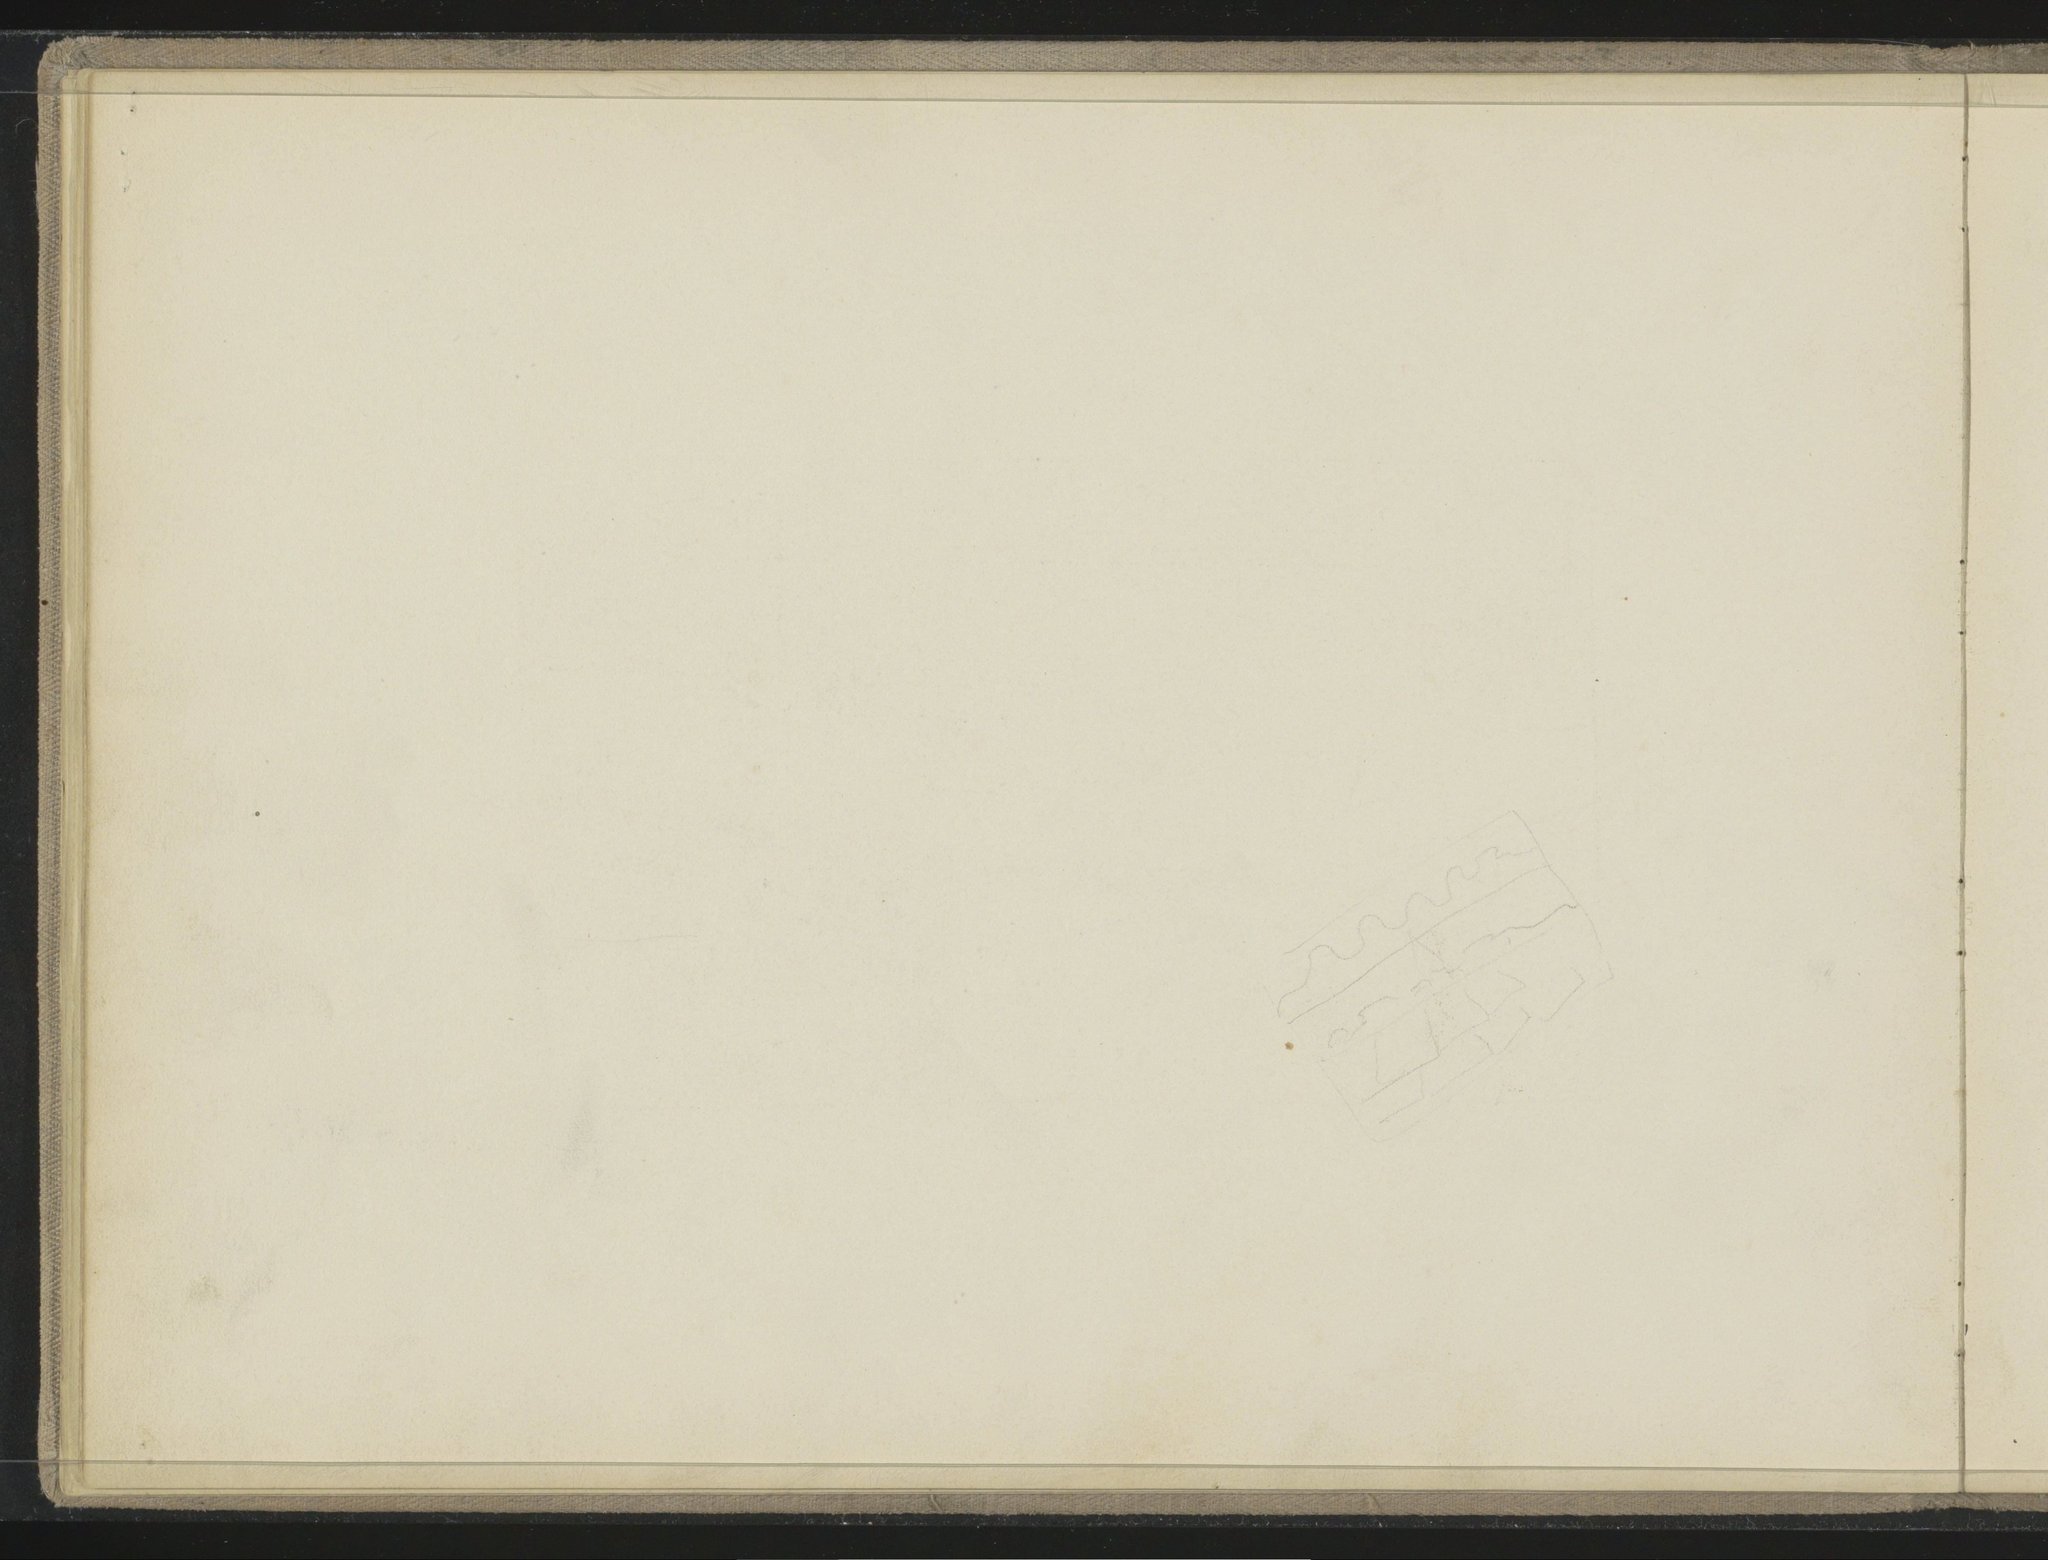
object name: sketchbook leaf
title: Studie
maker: chris huidekooper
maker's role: draughtsman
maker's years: 1878-1939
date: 1895-1896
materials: paper, pencil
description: Blad 19 verso uit een schetsboek met 32 bladen.